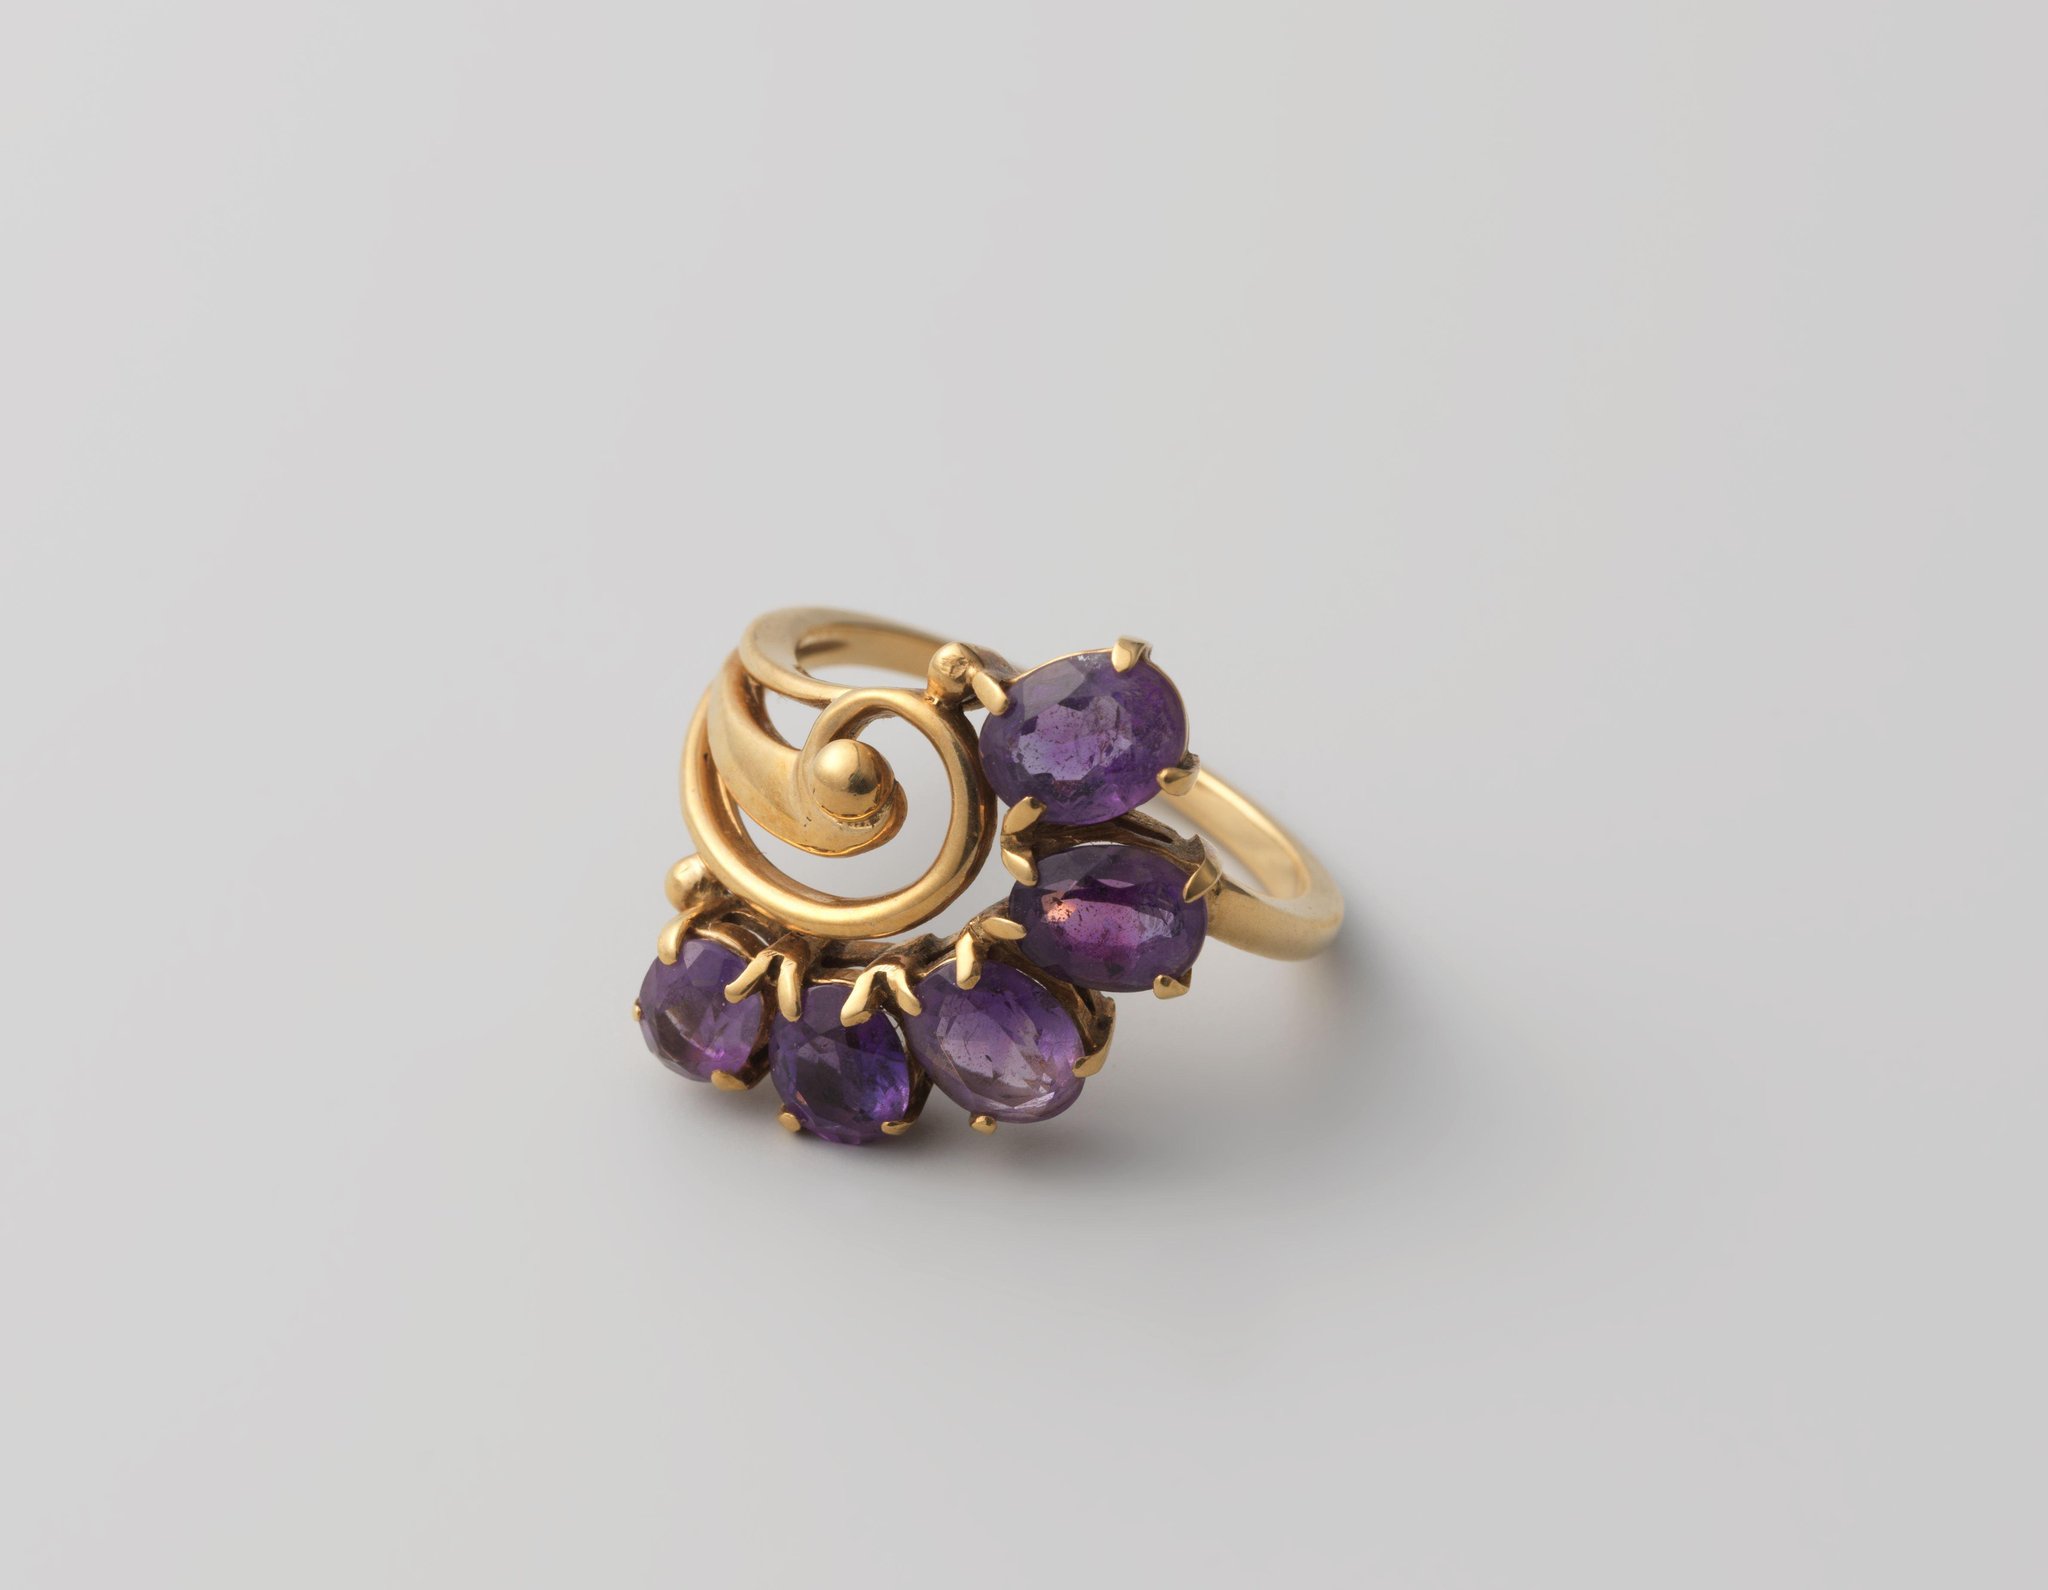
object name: ring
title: Ring van goud met vijf amethisten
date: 1951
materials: gemstone, gold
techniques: grinding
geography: zeist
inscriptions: alloy mark: ‘eikenblad 585’, maker's mark: ‘GVK’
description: Ring van goud met vijf amethisten. Rond een krul van draadwerk zijn vijf amethisten geplaatst, oplopend van grootte.